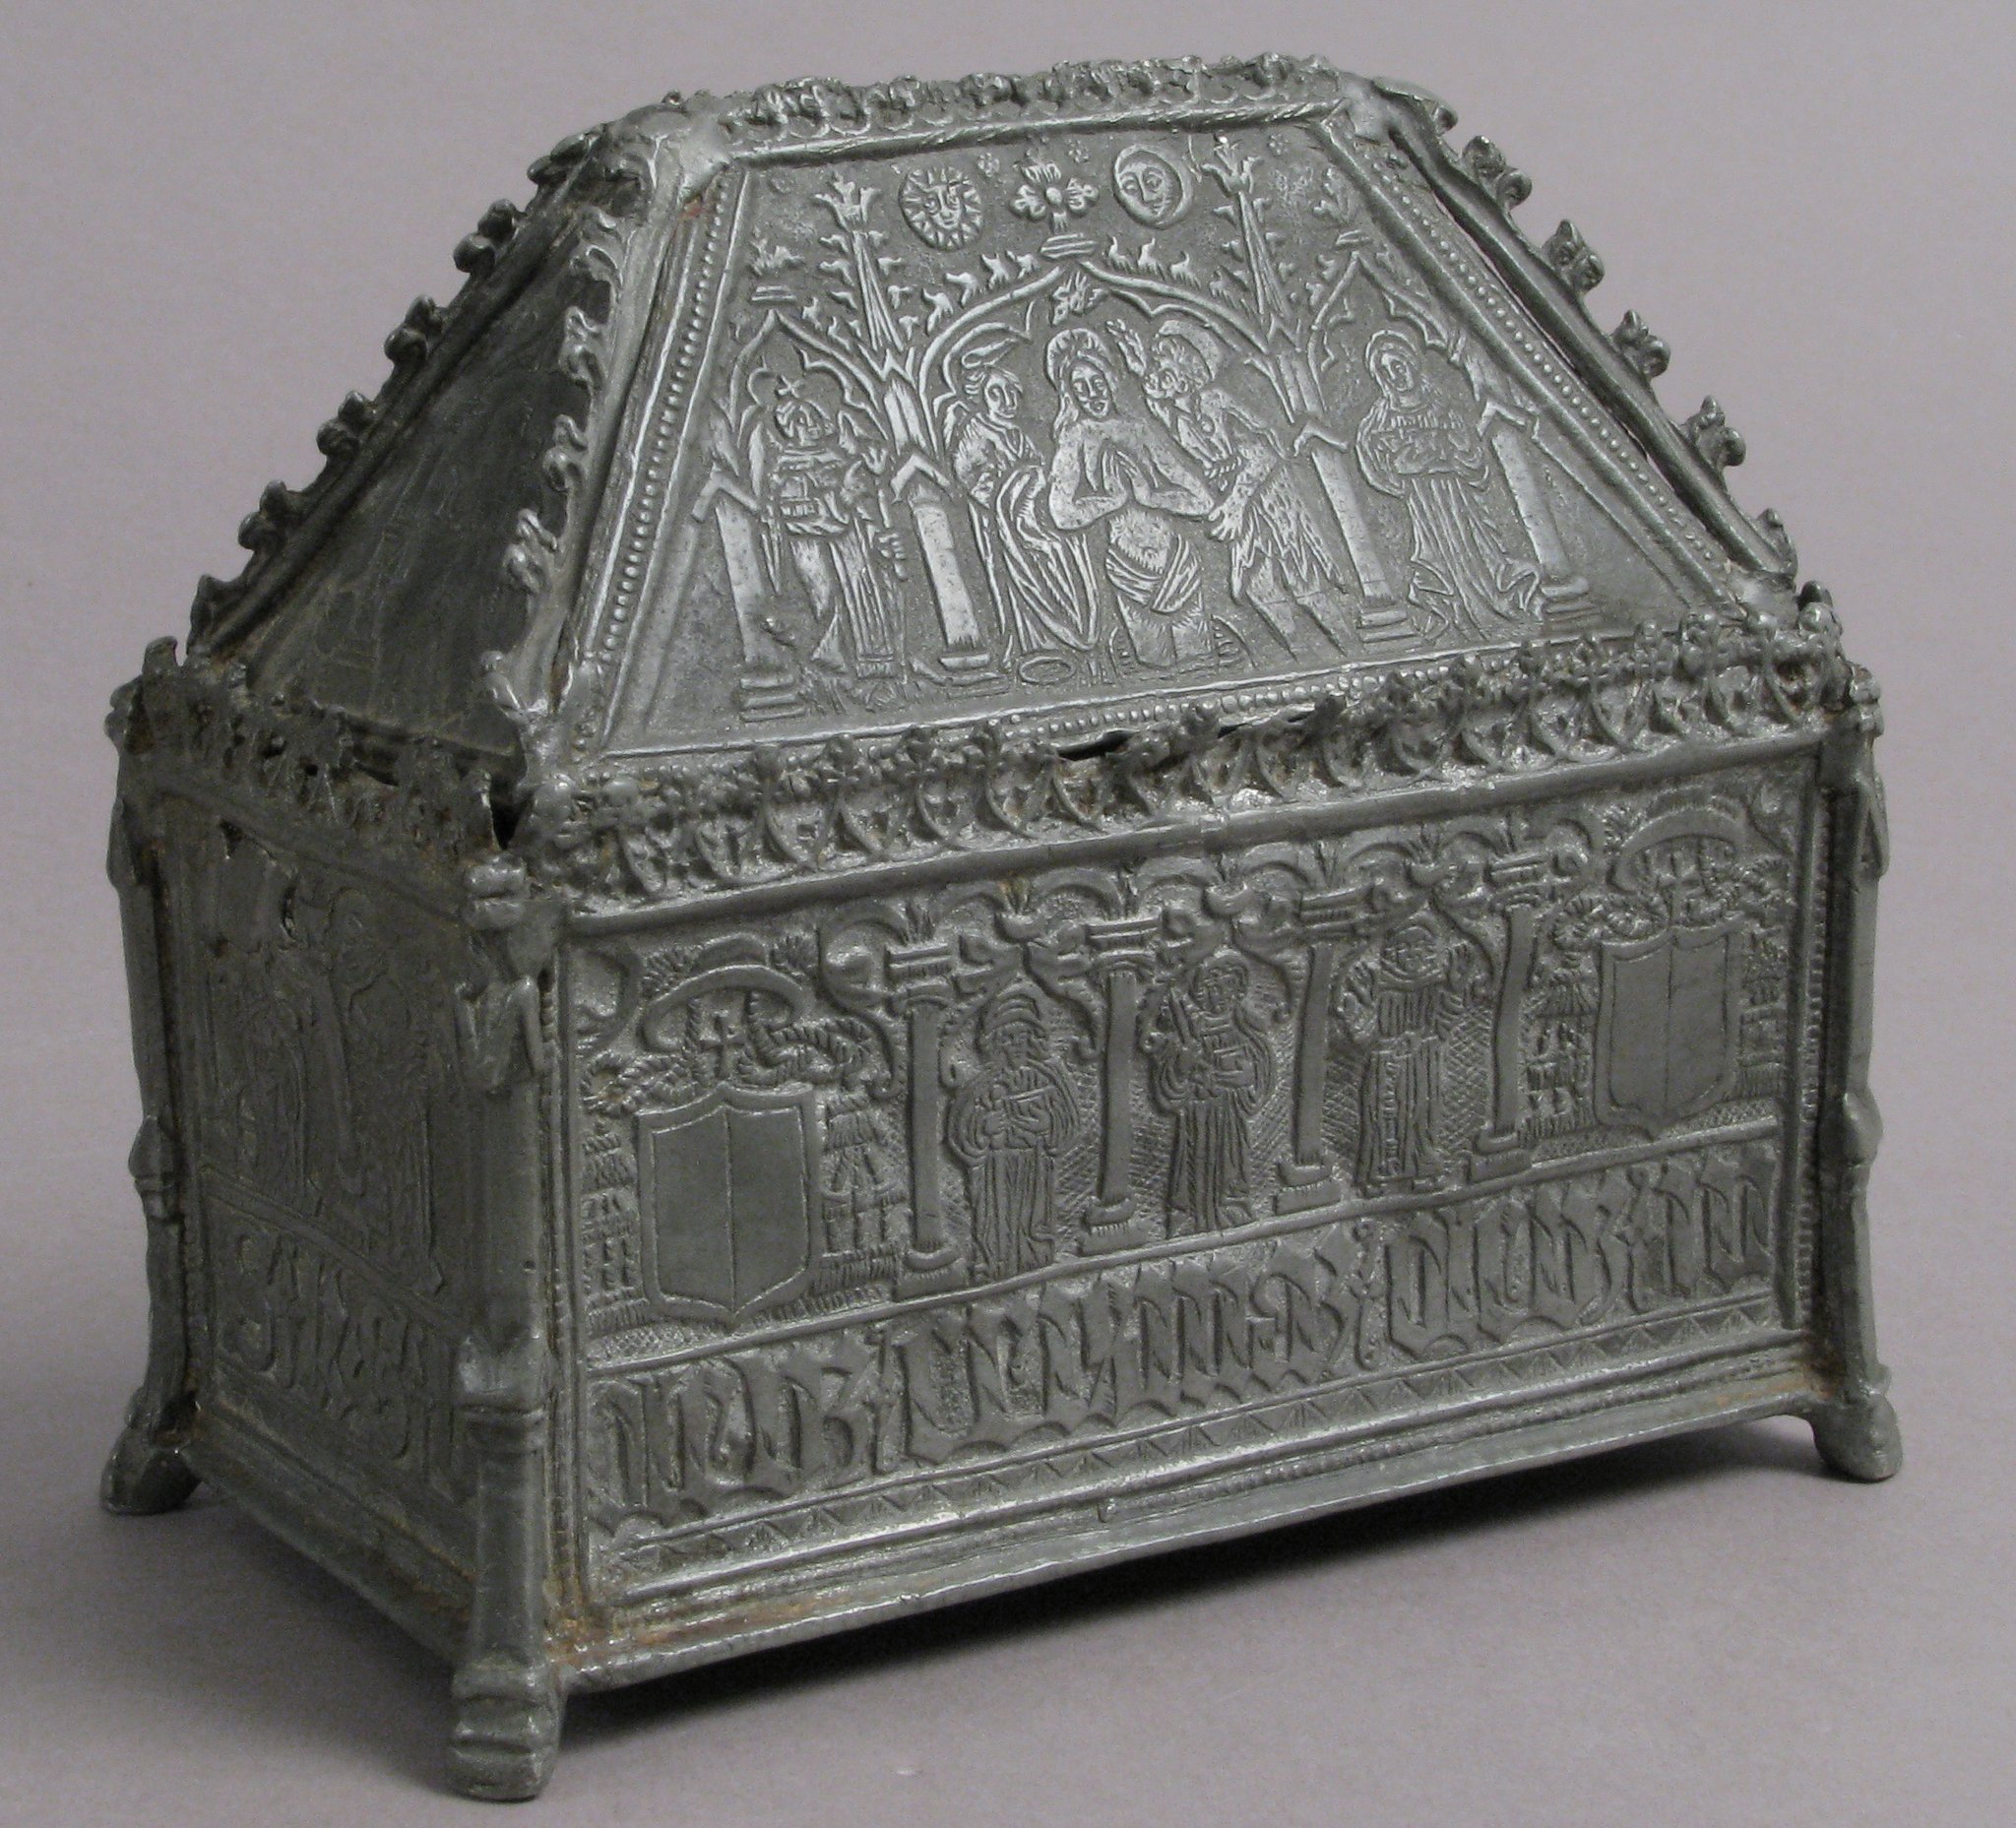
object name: olearium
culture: german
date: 1467-1533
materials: lead